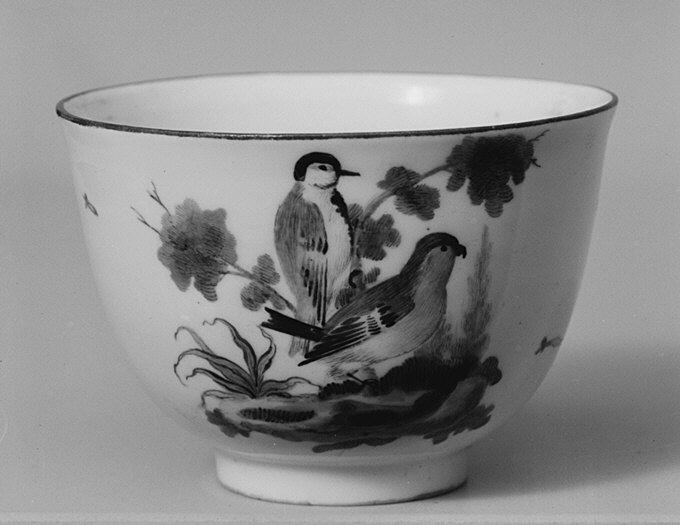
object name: cup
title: Cup (part of a service)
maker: frankenthal porcelain manufactory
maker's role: manufactory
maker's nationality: german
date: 1770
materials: hard paste porcelain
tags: birds,flowers